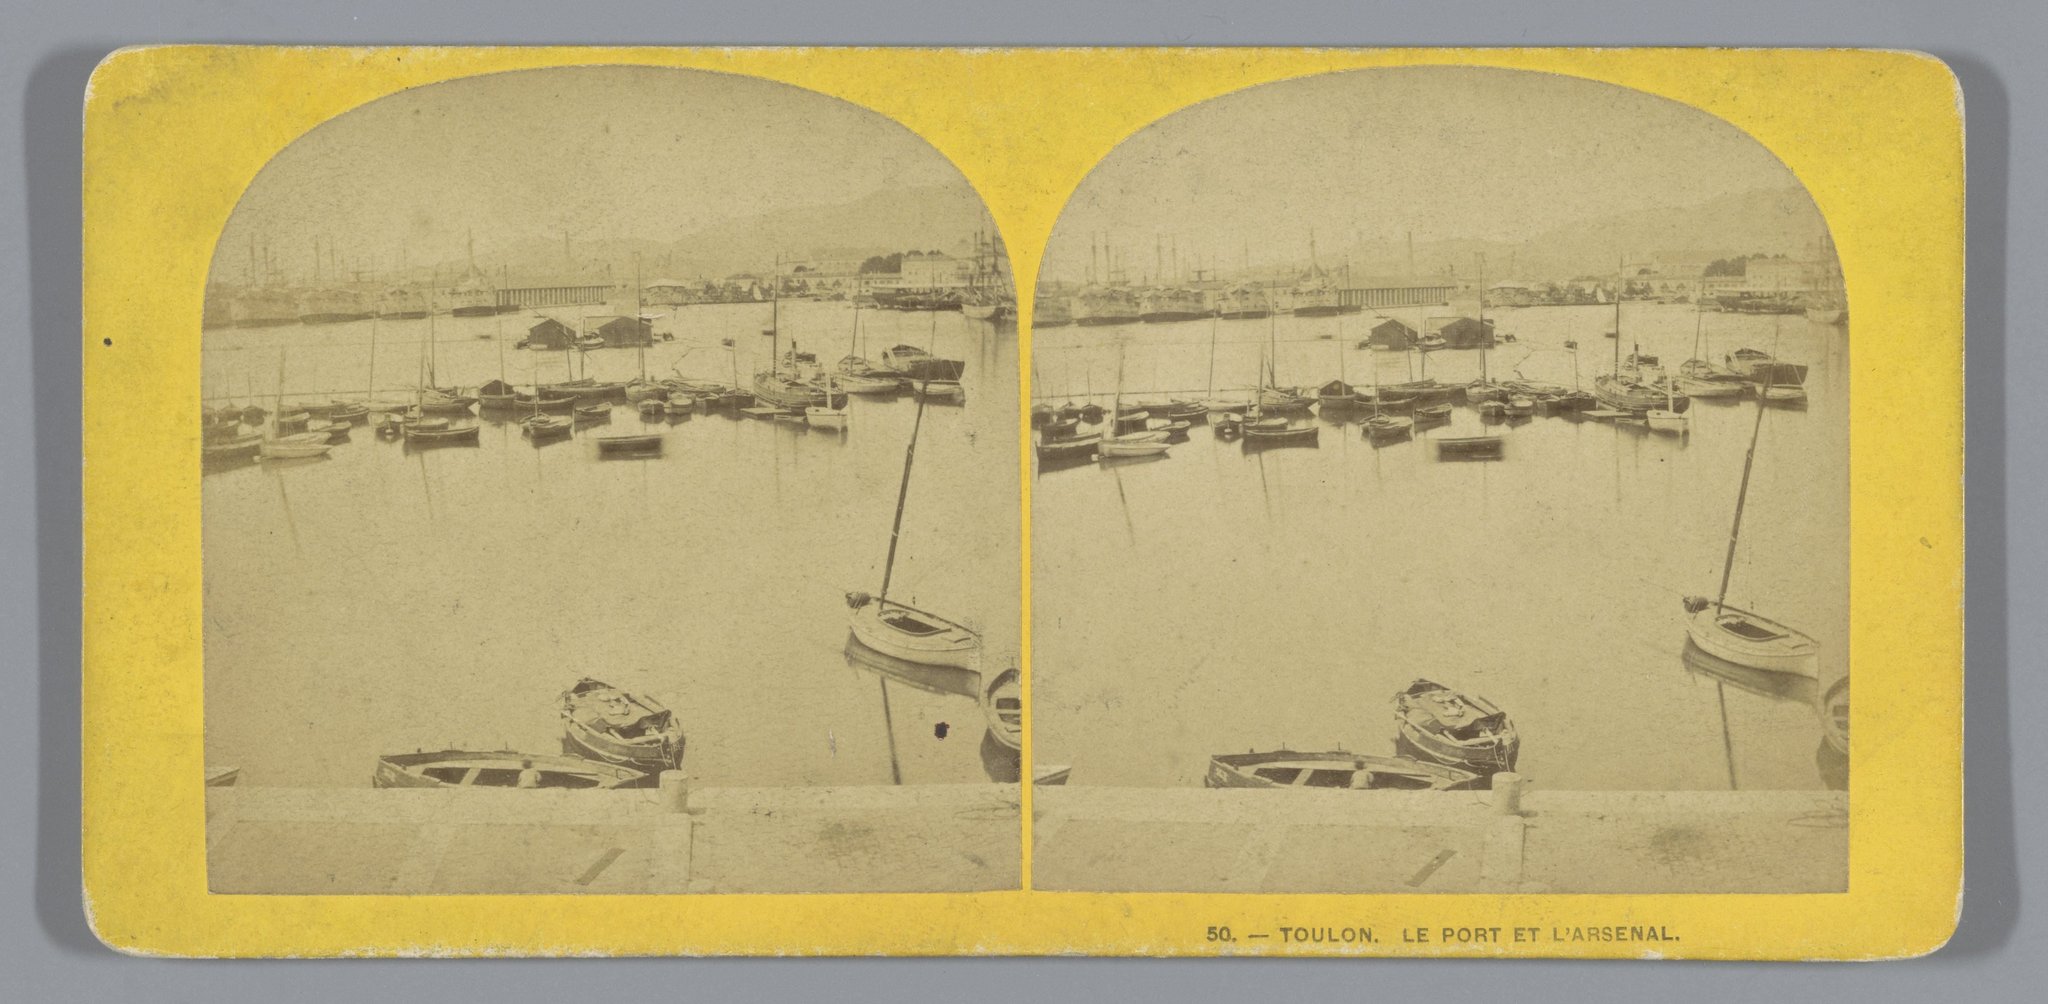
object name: stereograph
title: Toulon. Le port et l'Arsenal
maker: Anonymous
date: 1850-1880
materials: cardboard, photographic support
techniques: albumen print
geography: toulon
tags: harbour, toulon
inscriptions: number: ‘50.’